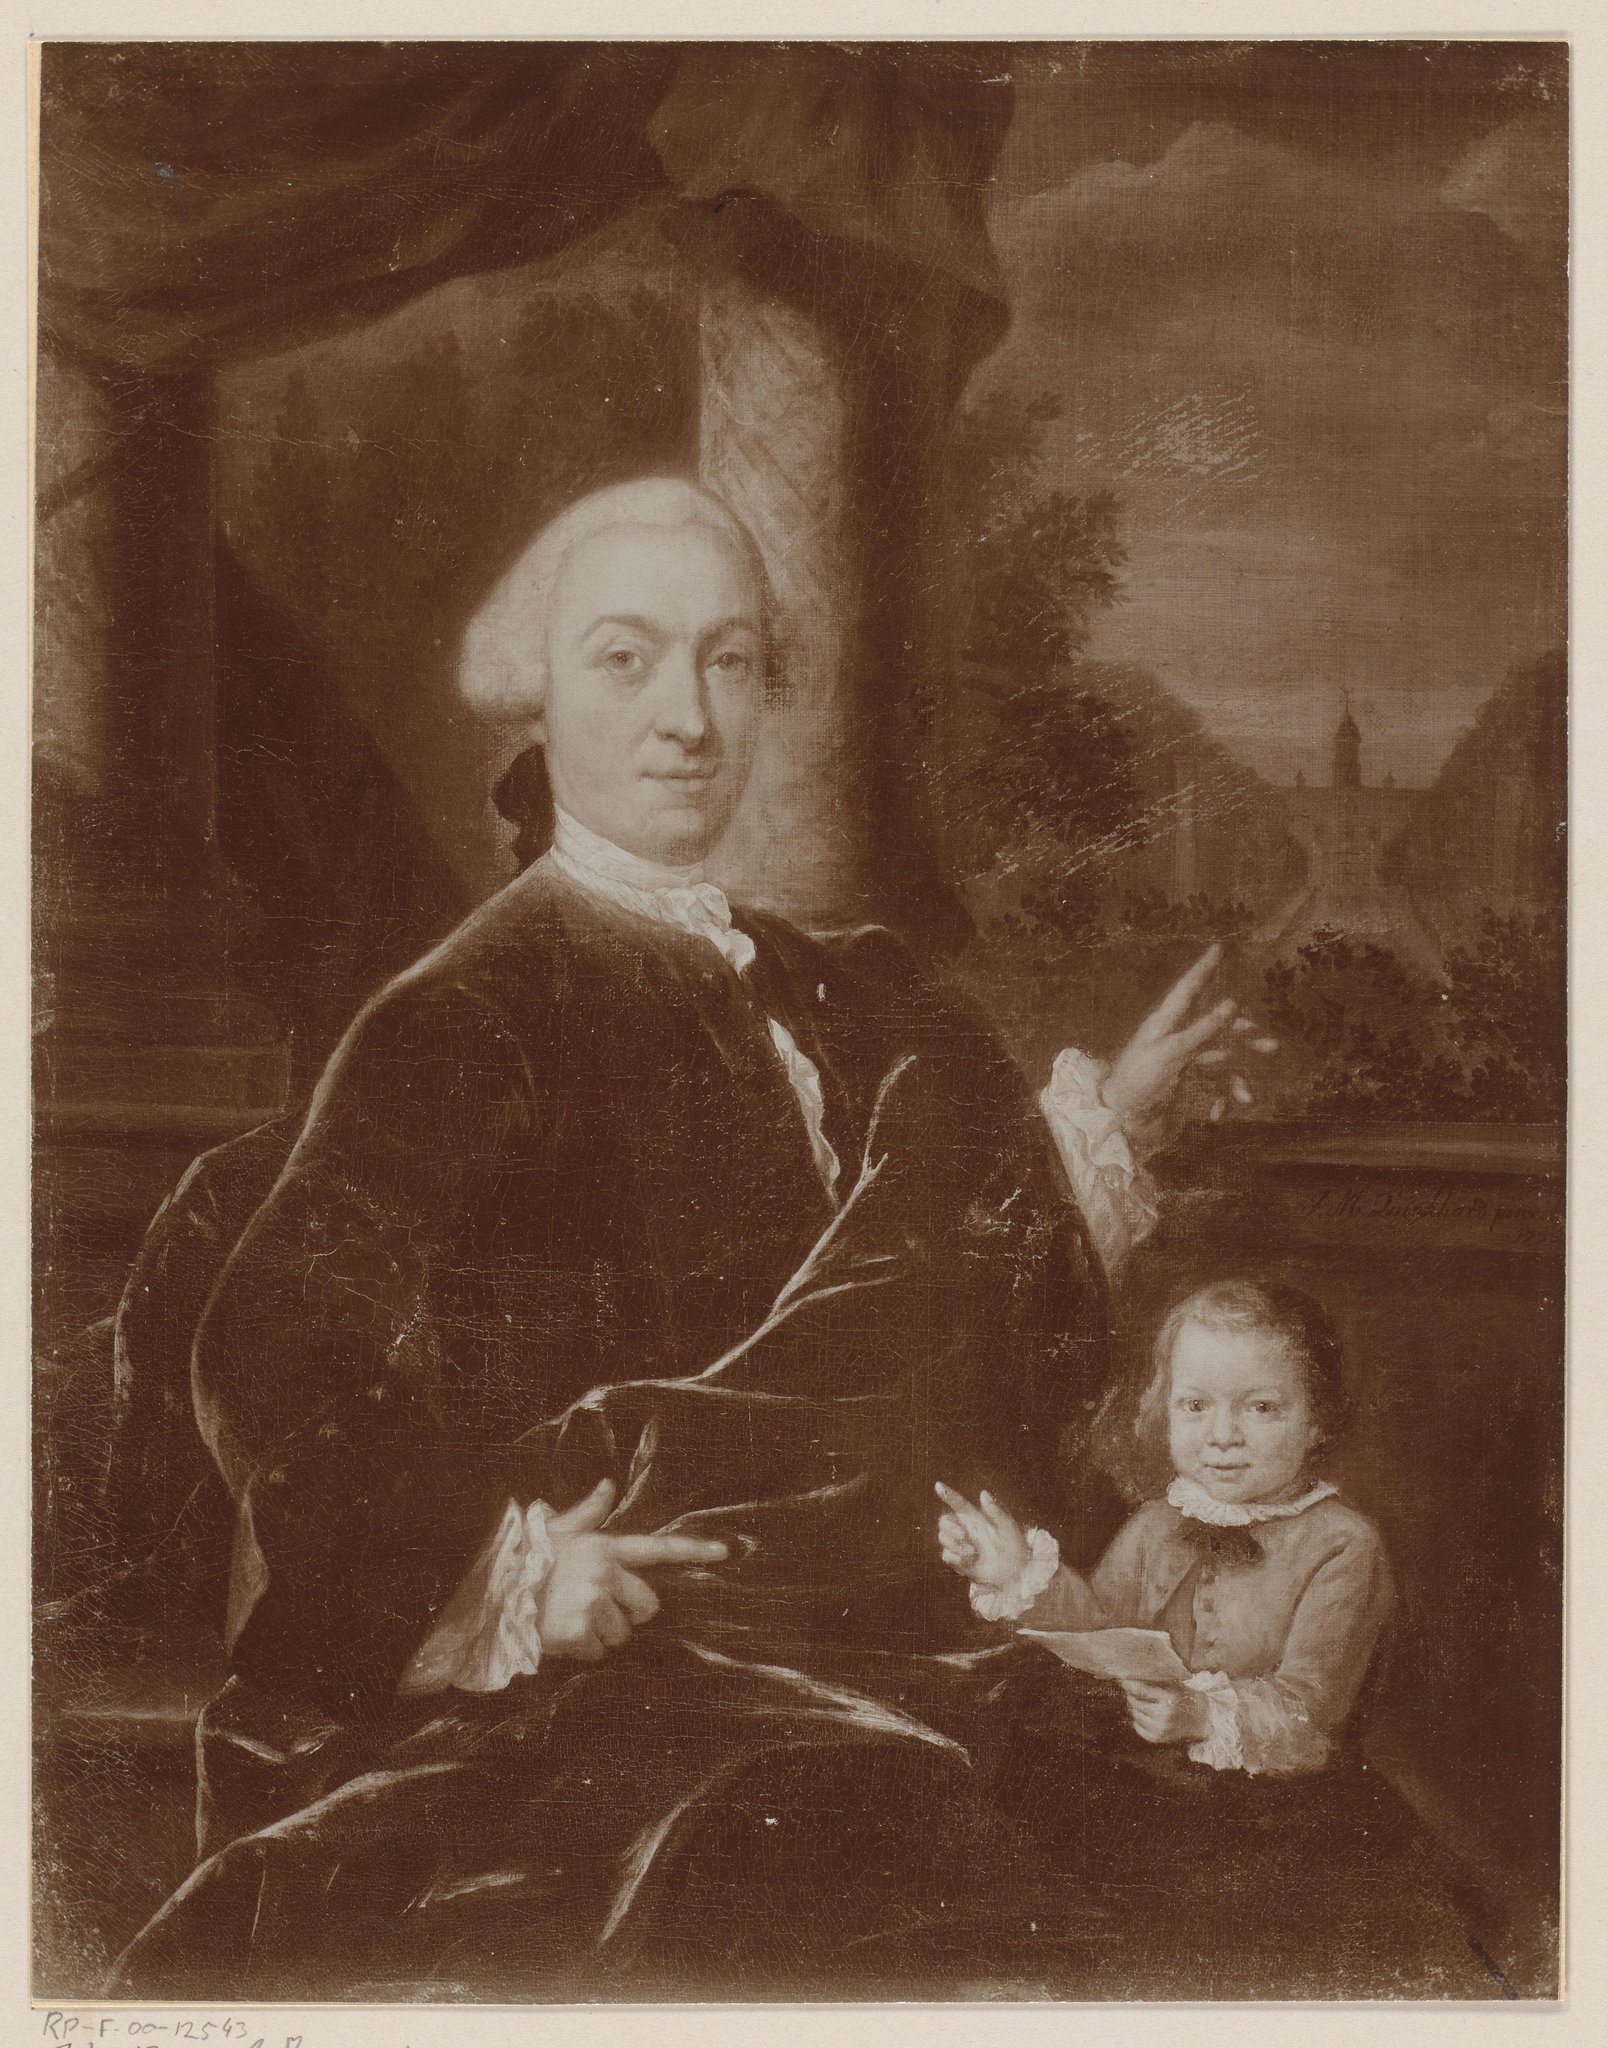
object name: reproduction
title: Fotoreproductie van een geschilderd portret van Jan van de Poll met zijn zoon, Harman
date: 1880-1910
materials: paper, cardboard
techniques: collodion silver print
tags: amsterdam, historical persons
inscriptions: collector's mark: Lugt 2228, inscription: ‘Roelofs Heubren e va Santen [?]’